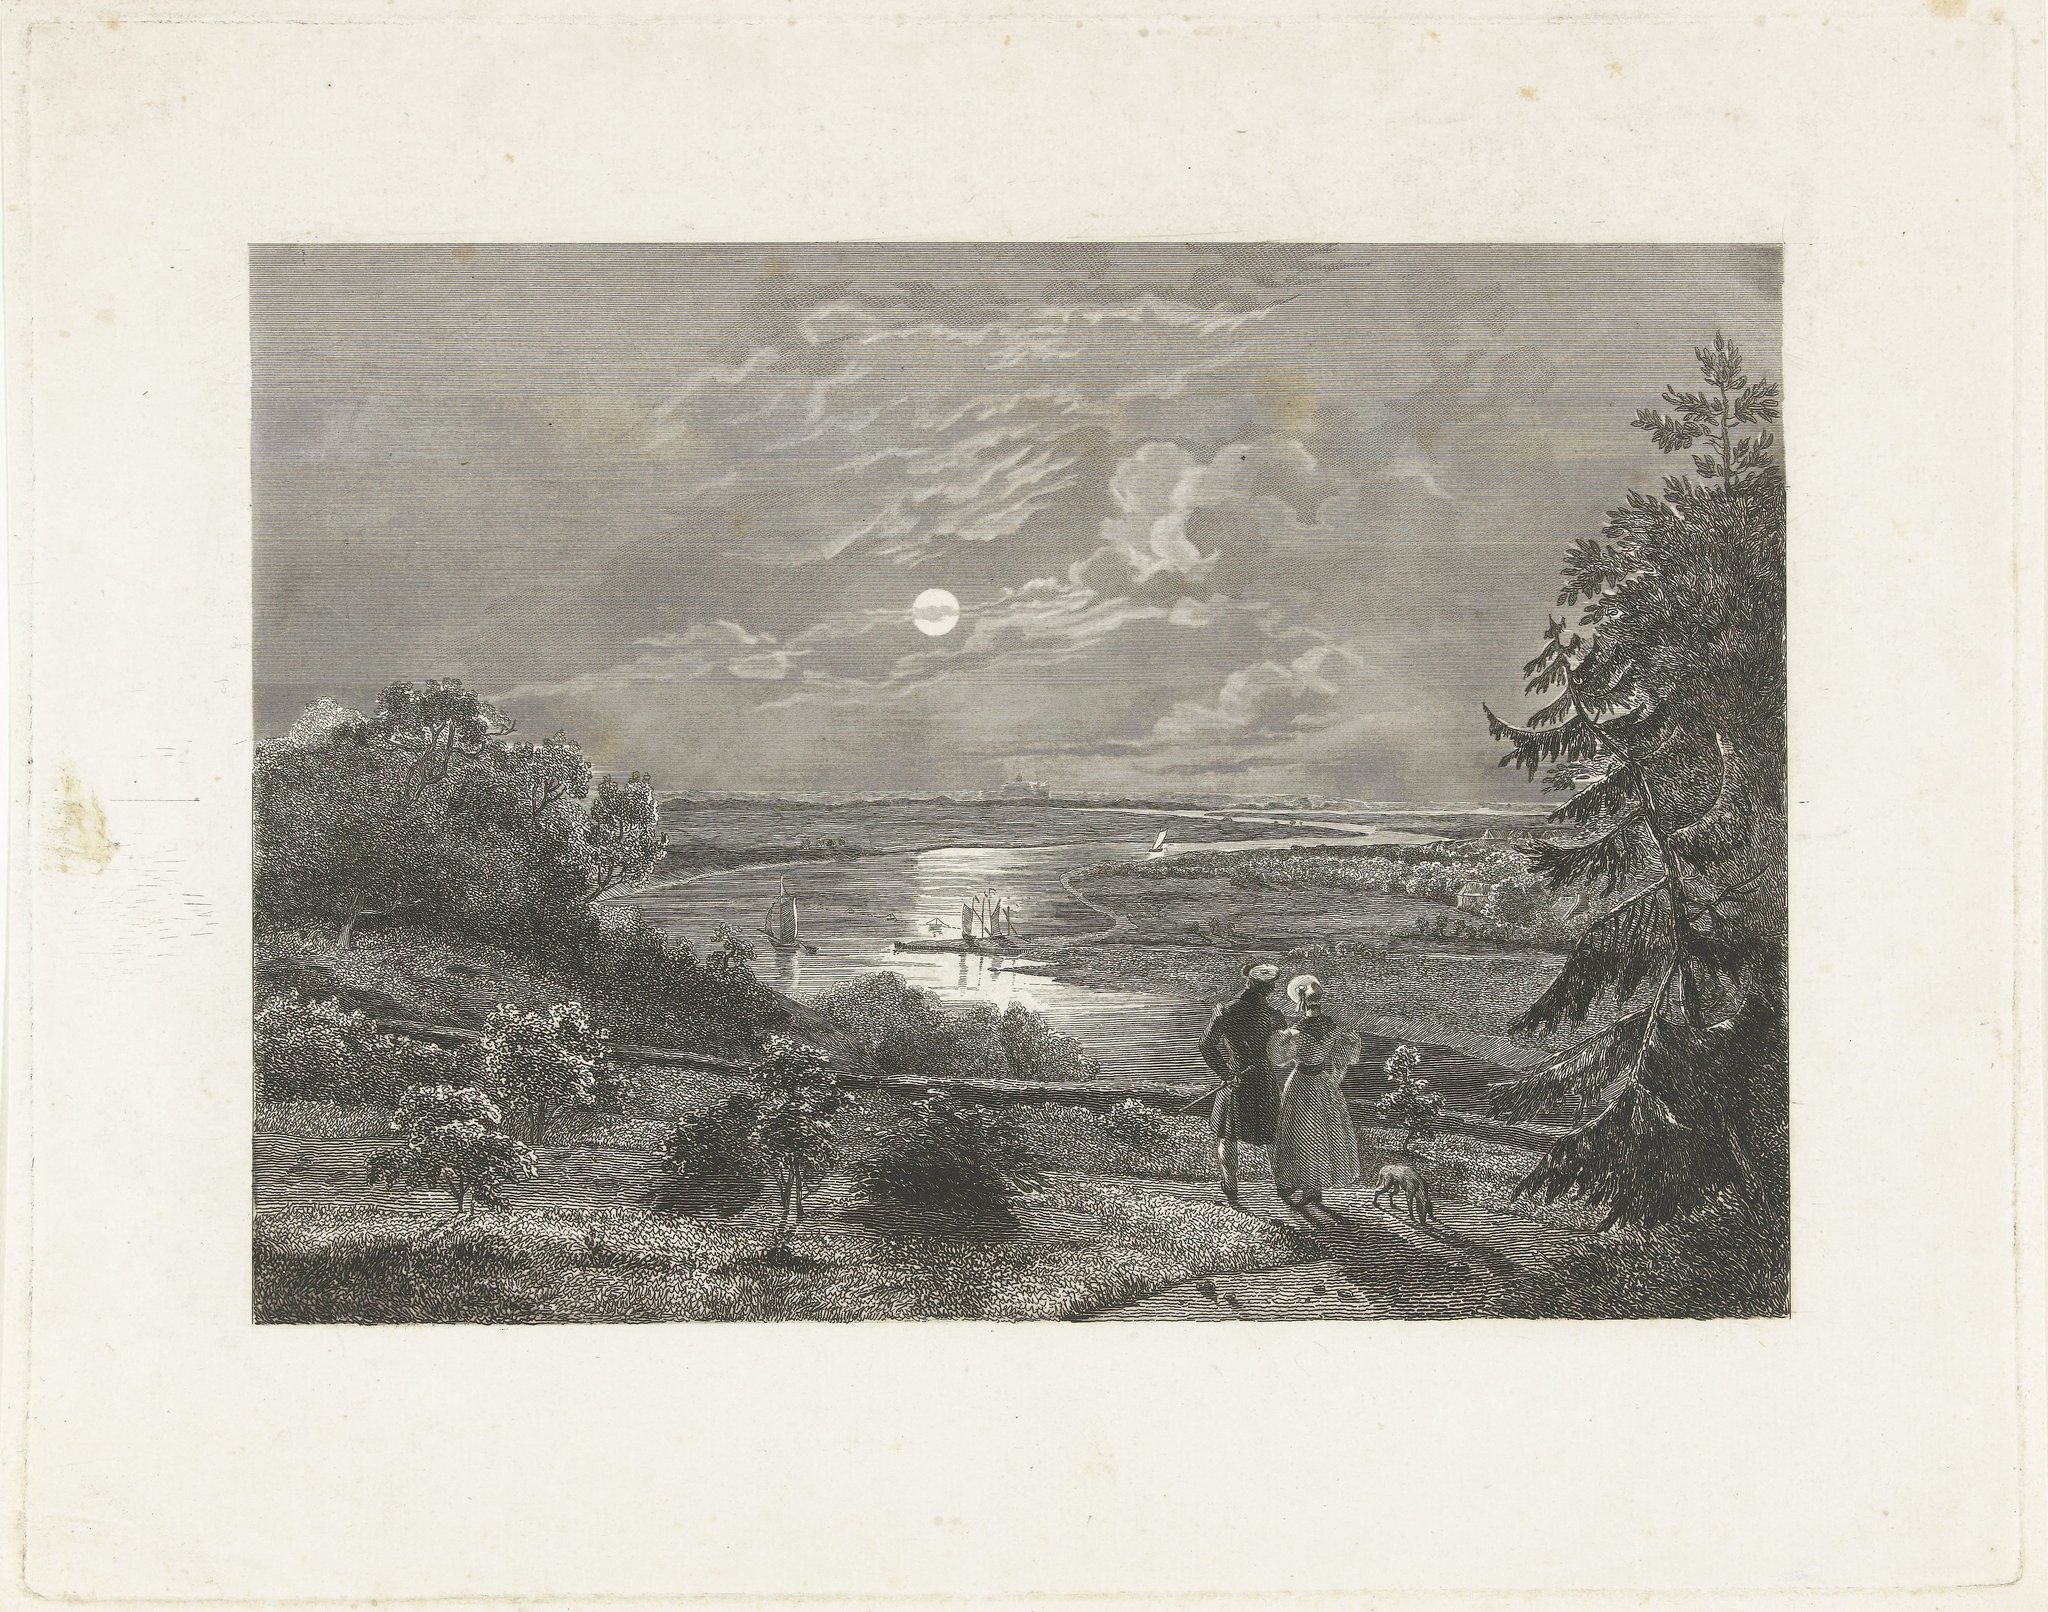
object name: print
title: Tafereelen uit de omstreken der stad Arnhem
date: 1838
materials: paper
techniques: engraving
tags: river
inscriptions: collector's mark: Lugt 2228